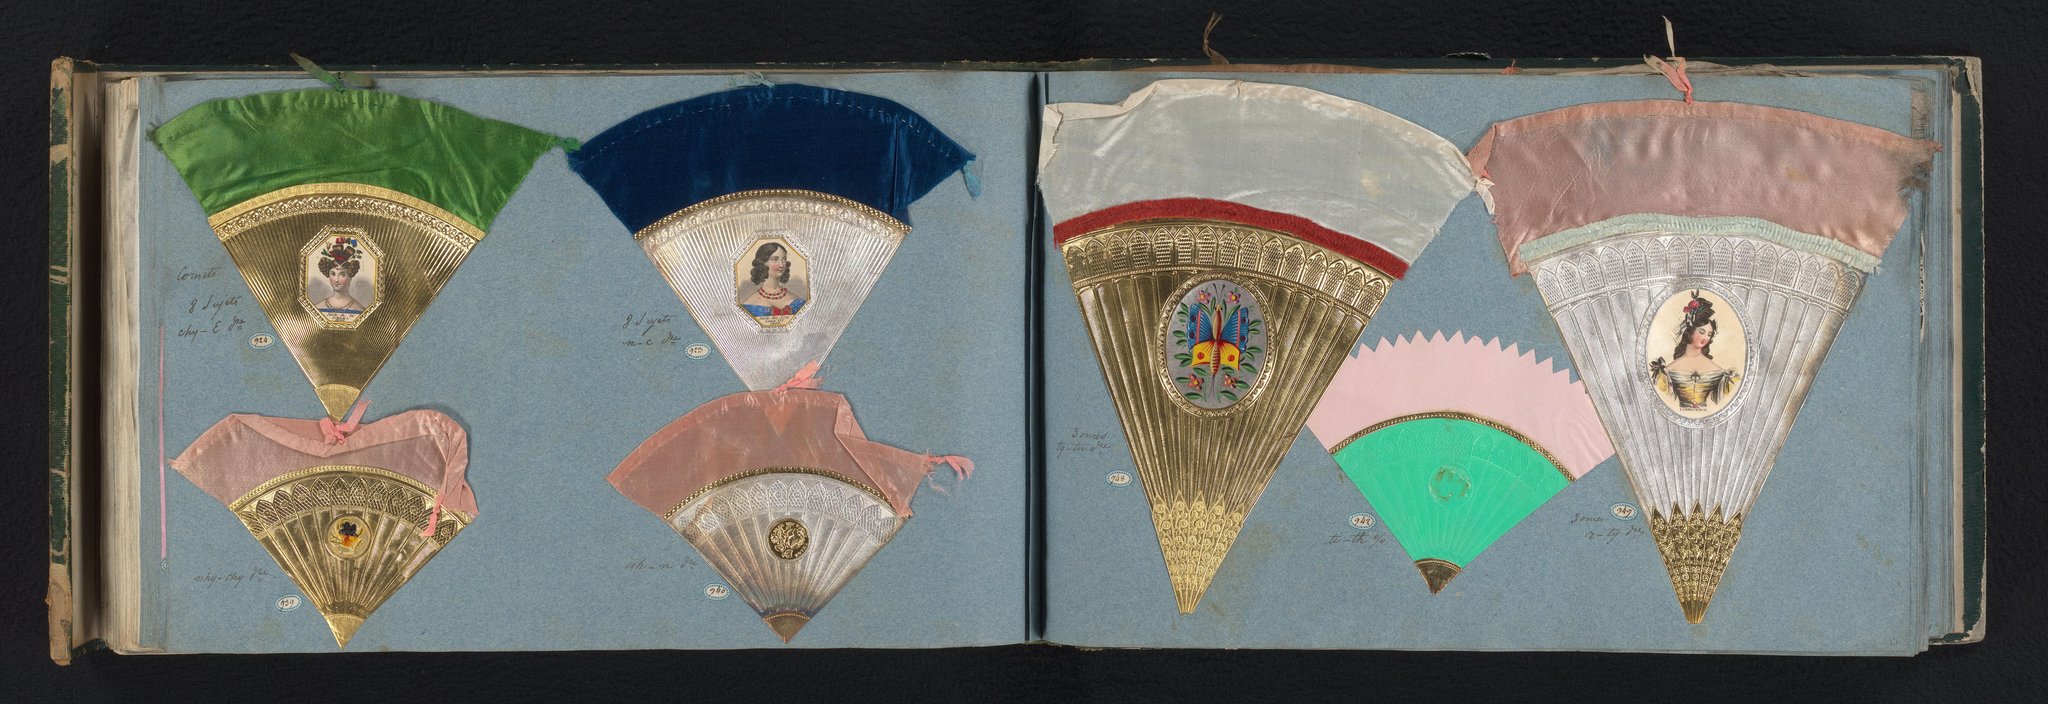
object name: sample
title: Twee bladzijden met stalen van waaierbladen van zijde en goud- en zilverkleurig metaalpapier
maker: Anonymous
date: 1830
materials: gold leaf, ink, paper, silk, silver leaf, watercolor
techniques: manufacturing, etching, hand coloring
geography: france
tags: ornaments ~ art, fan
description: Twee bladzijden met 7 stalen van v-vormige waaierbladen van zijde in verschillende kleuren en goud- en zilverkleurig metaalpapier waarop verschillende vignetten met vrouwenfiguren of bloemen en vlinders zijn geplakt. Alle stalen voorzien van etiketten met nummers (924-949) en handgeschreven codes. Onderdeel van het stalenboek geschonken door de dames Van Rijn, vermoedelijk van een Franse papierfabrikant van luxe papieren, of diens vertegenwoordiger in Nederland, ca. 1830.